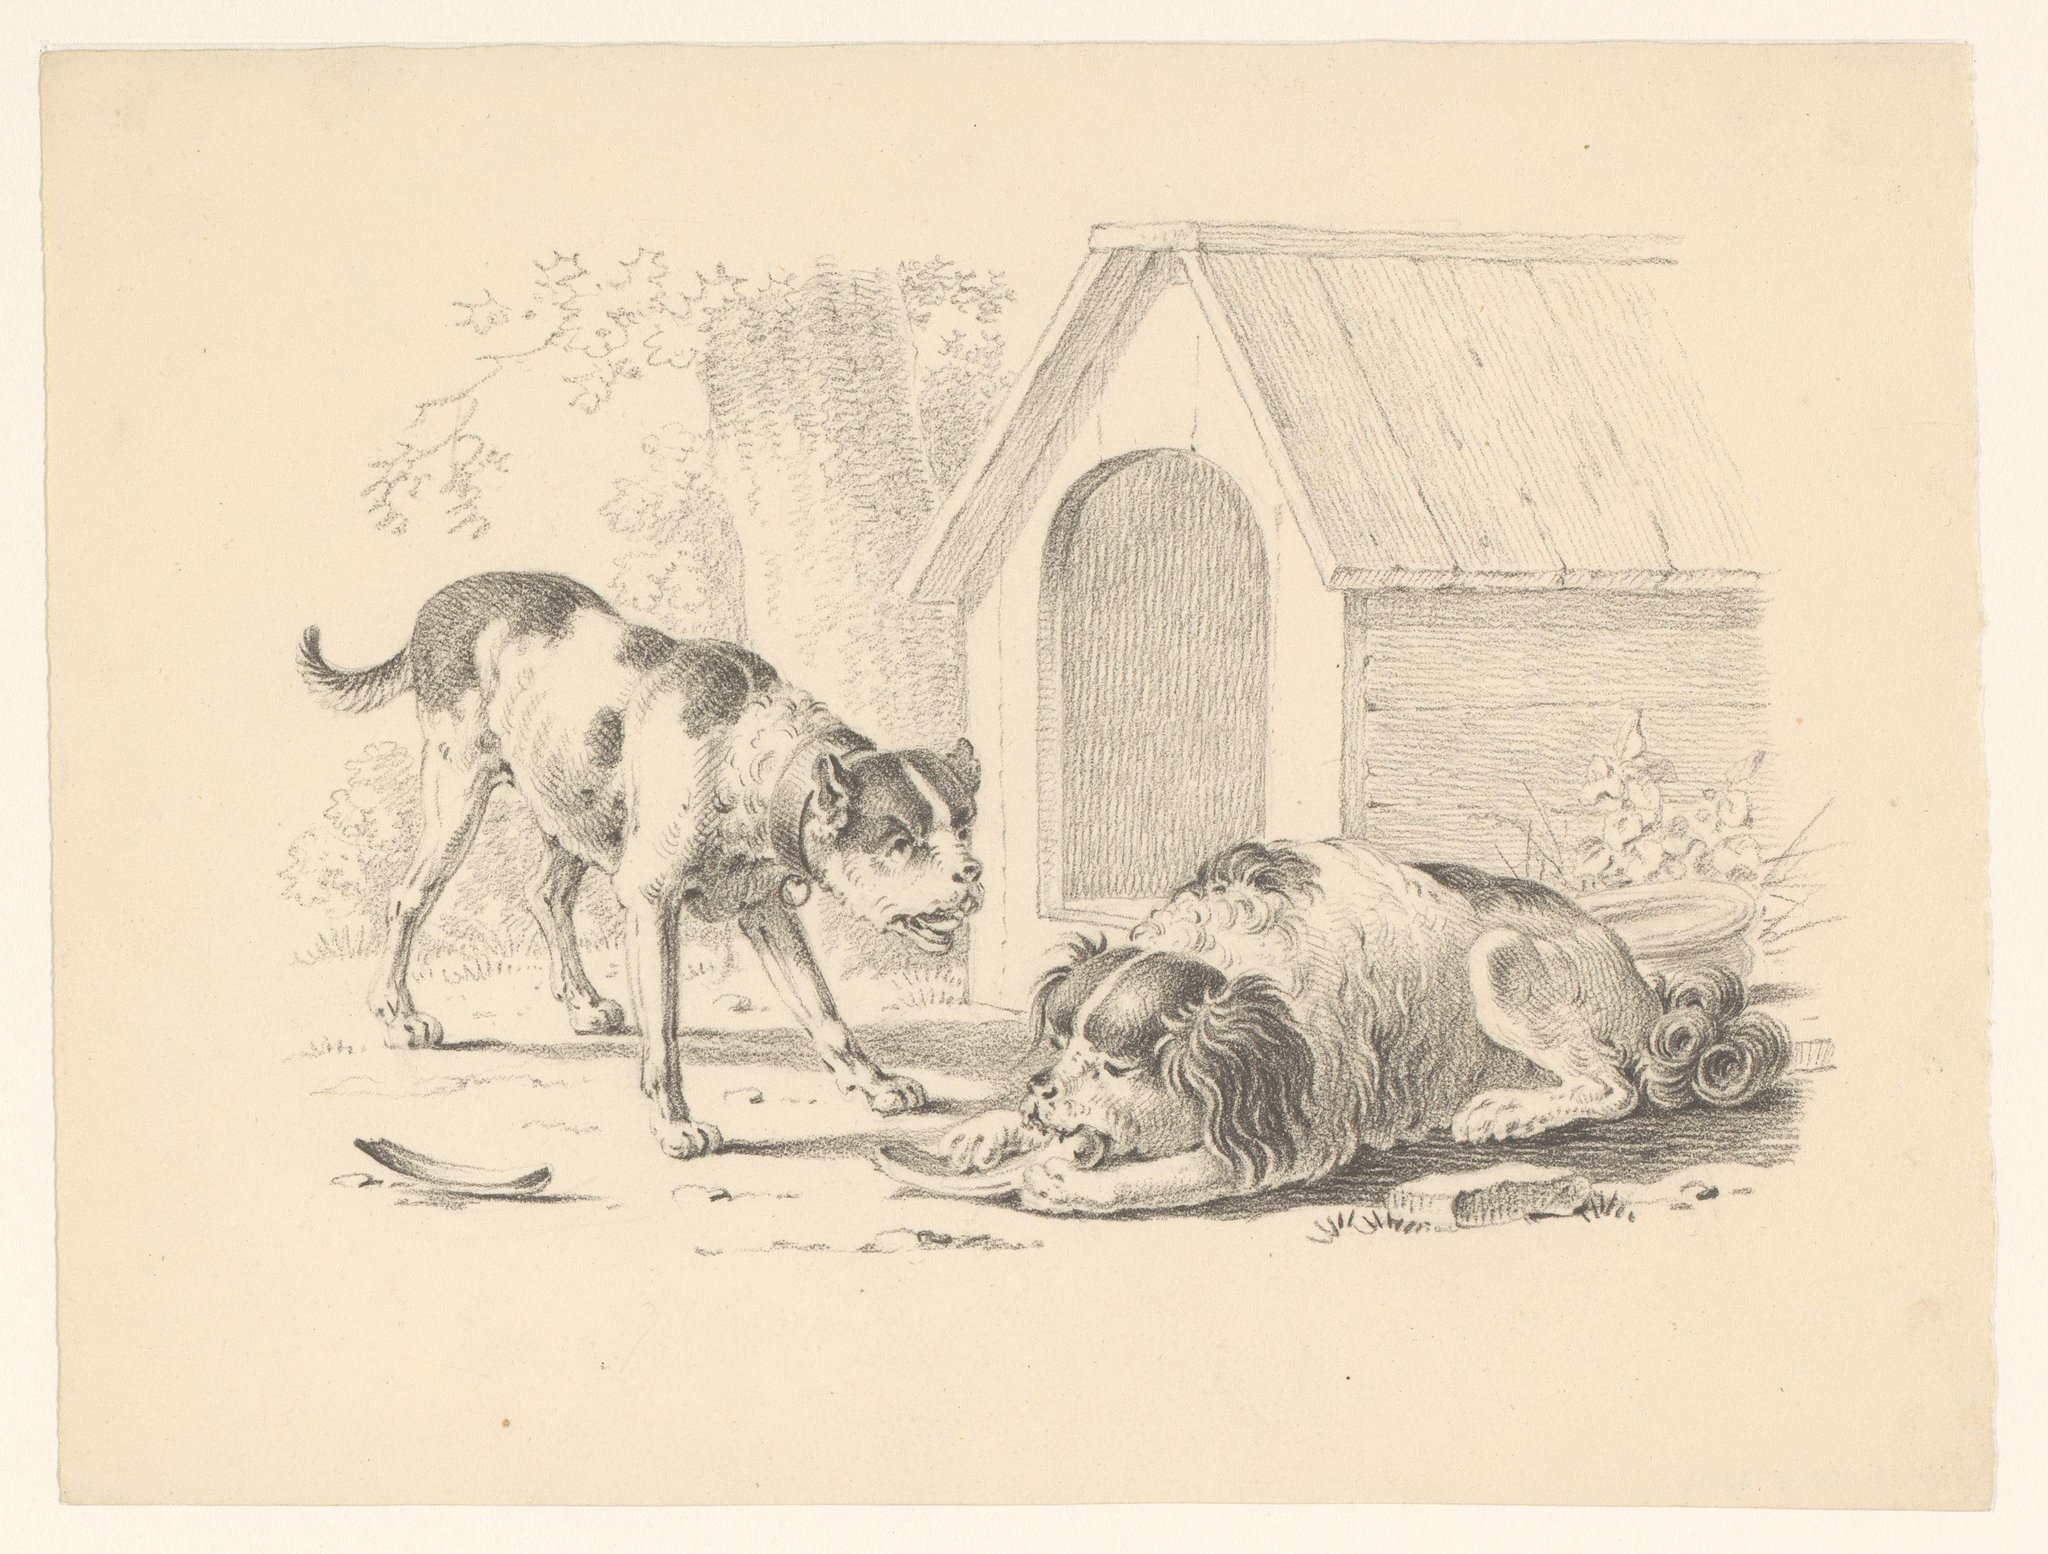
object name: print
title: Twee honden bij een hondenhok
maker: Anonymous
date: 1800-1899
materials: paper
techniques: lithograph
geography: netherlands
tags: dog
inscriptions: collector's mark: Lugt 2228